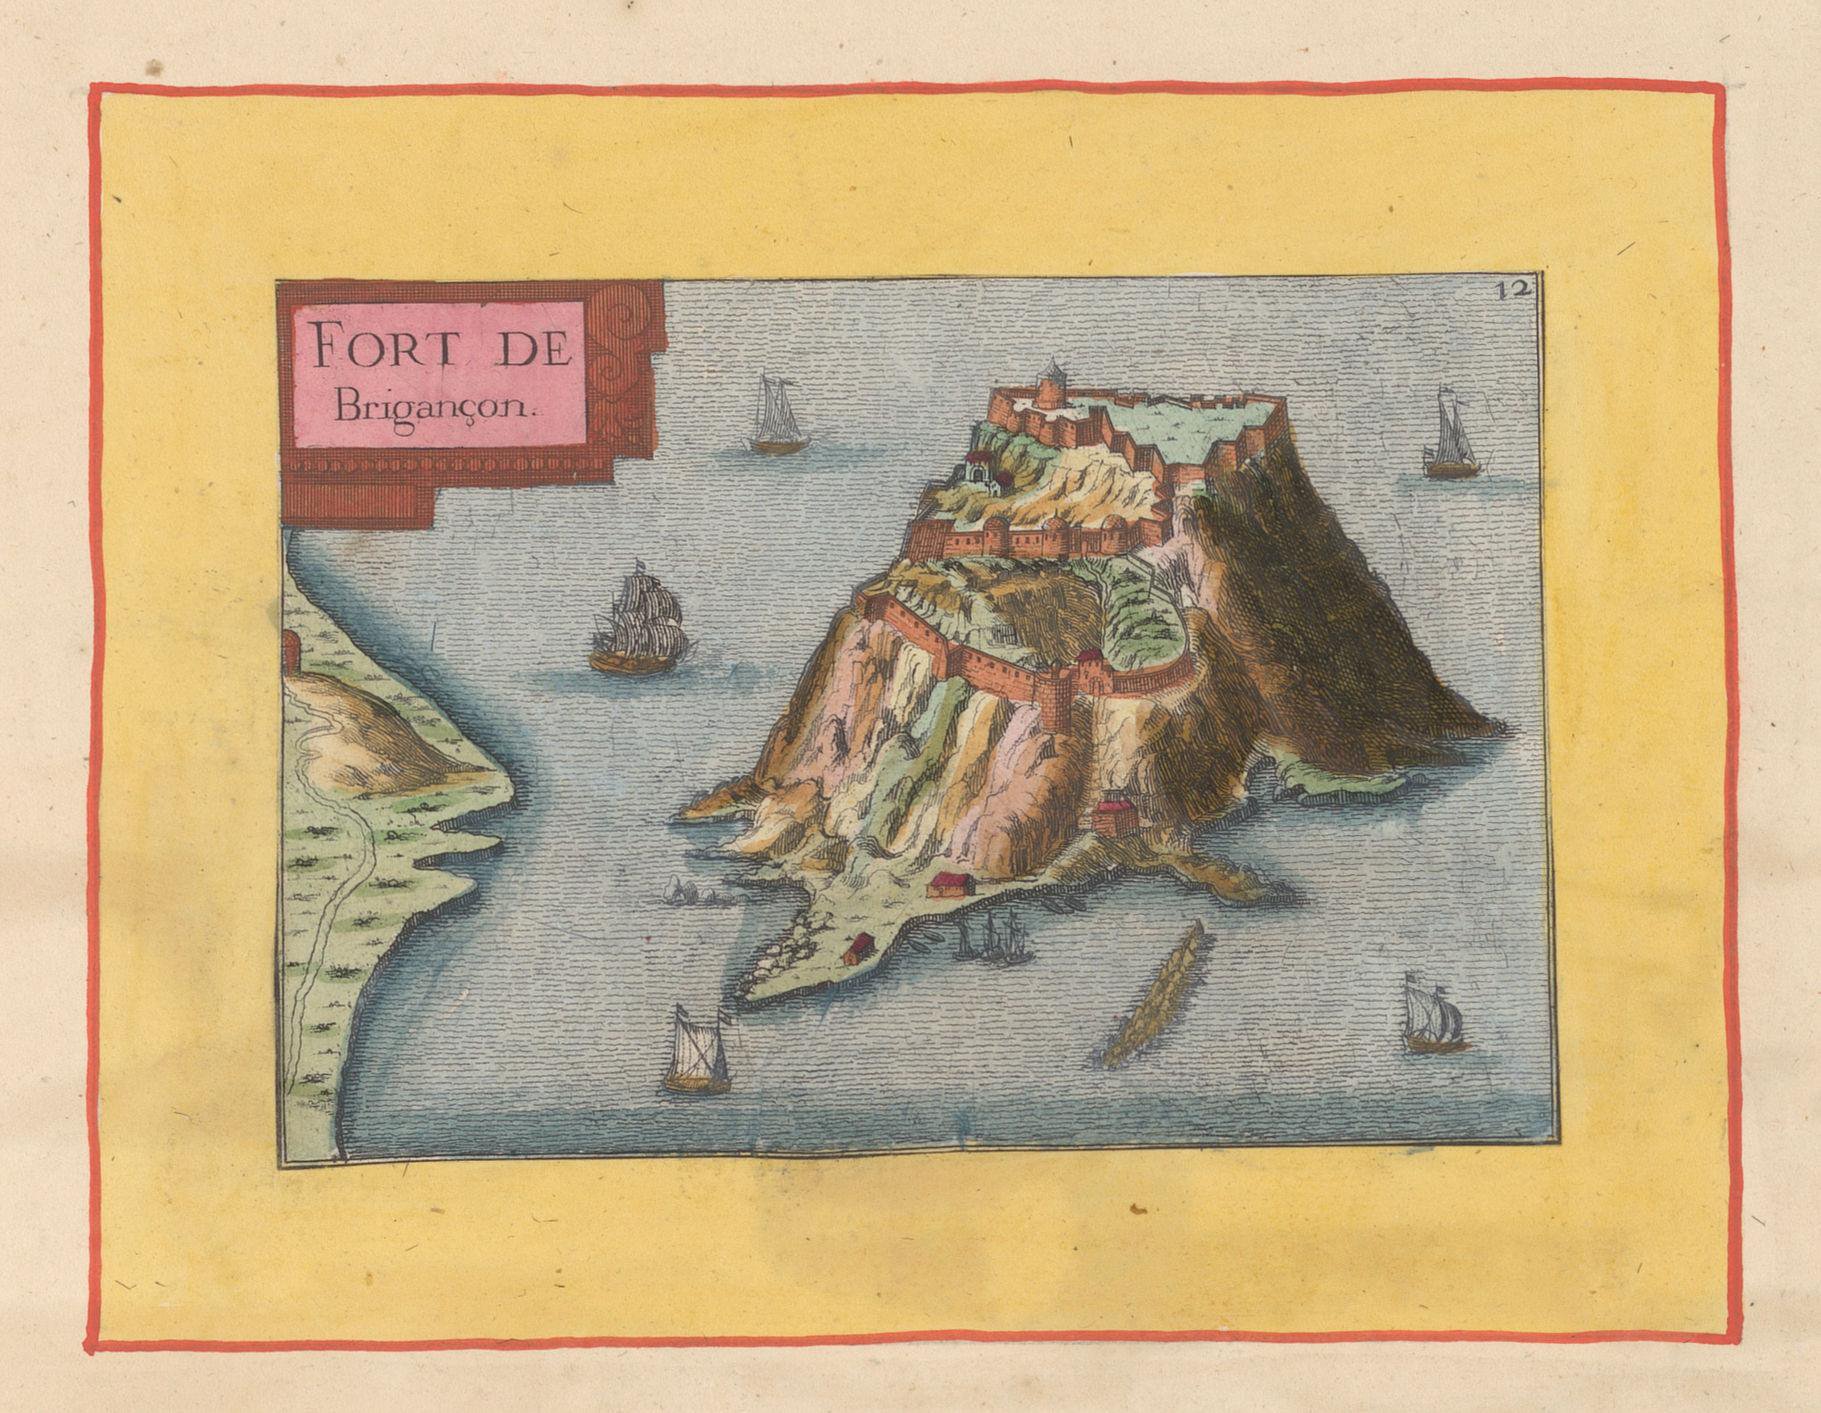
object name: album leaf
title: Fort de Brigançon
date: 1638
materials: paper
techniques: engraving, etching, hand coloring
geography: the hague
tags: fortress, maps of cities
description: Prent uit: Tassin, Christophe. Les plans et profils de toutes les principales villes et lieux considérables de France (...). Parijs: Michel van Lochom, 1638, prent 12 uit het deel 'Provence'.